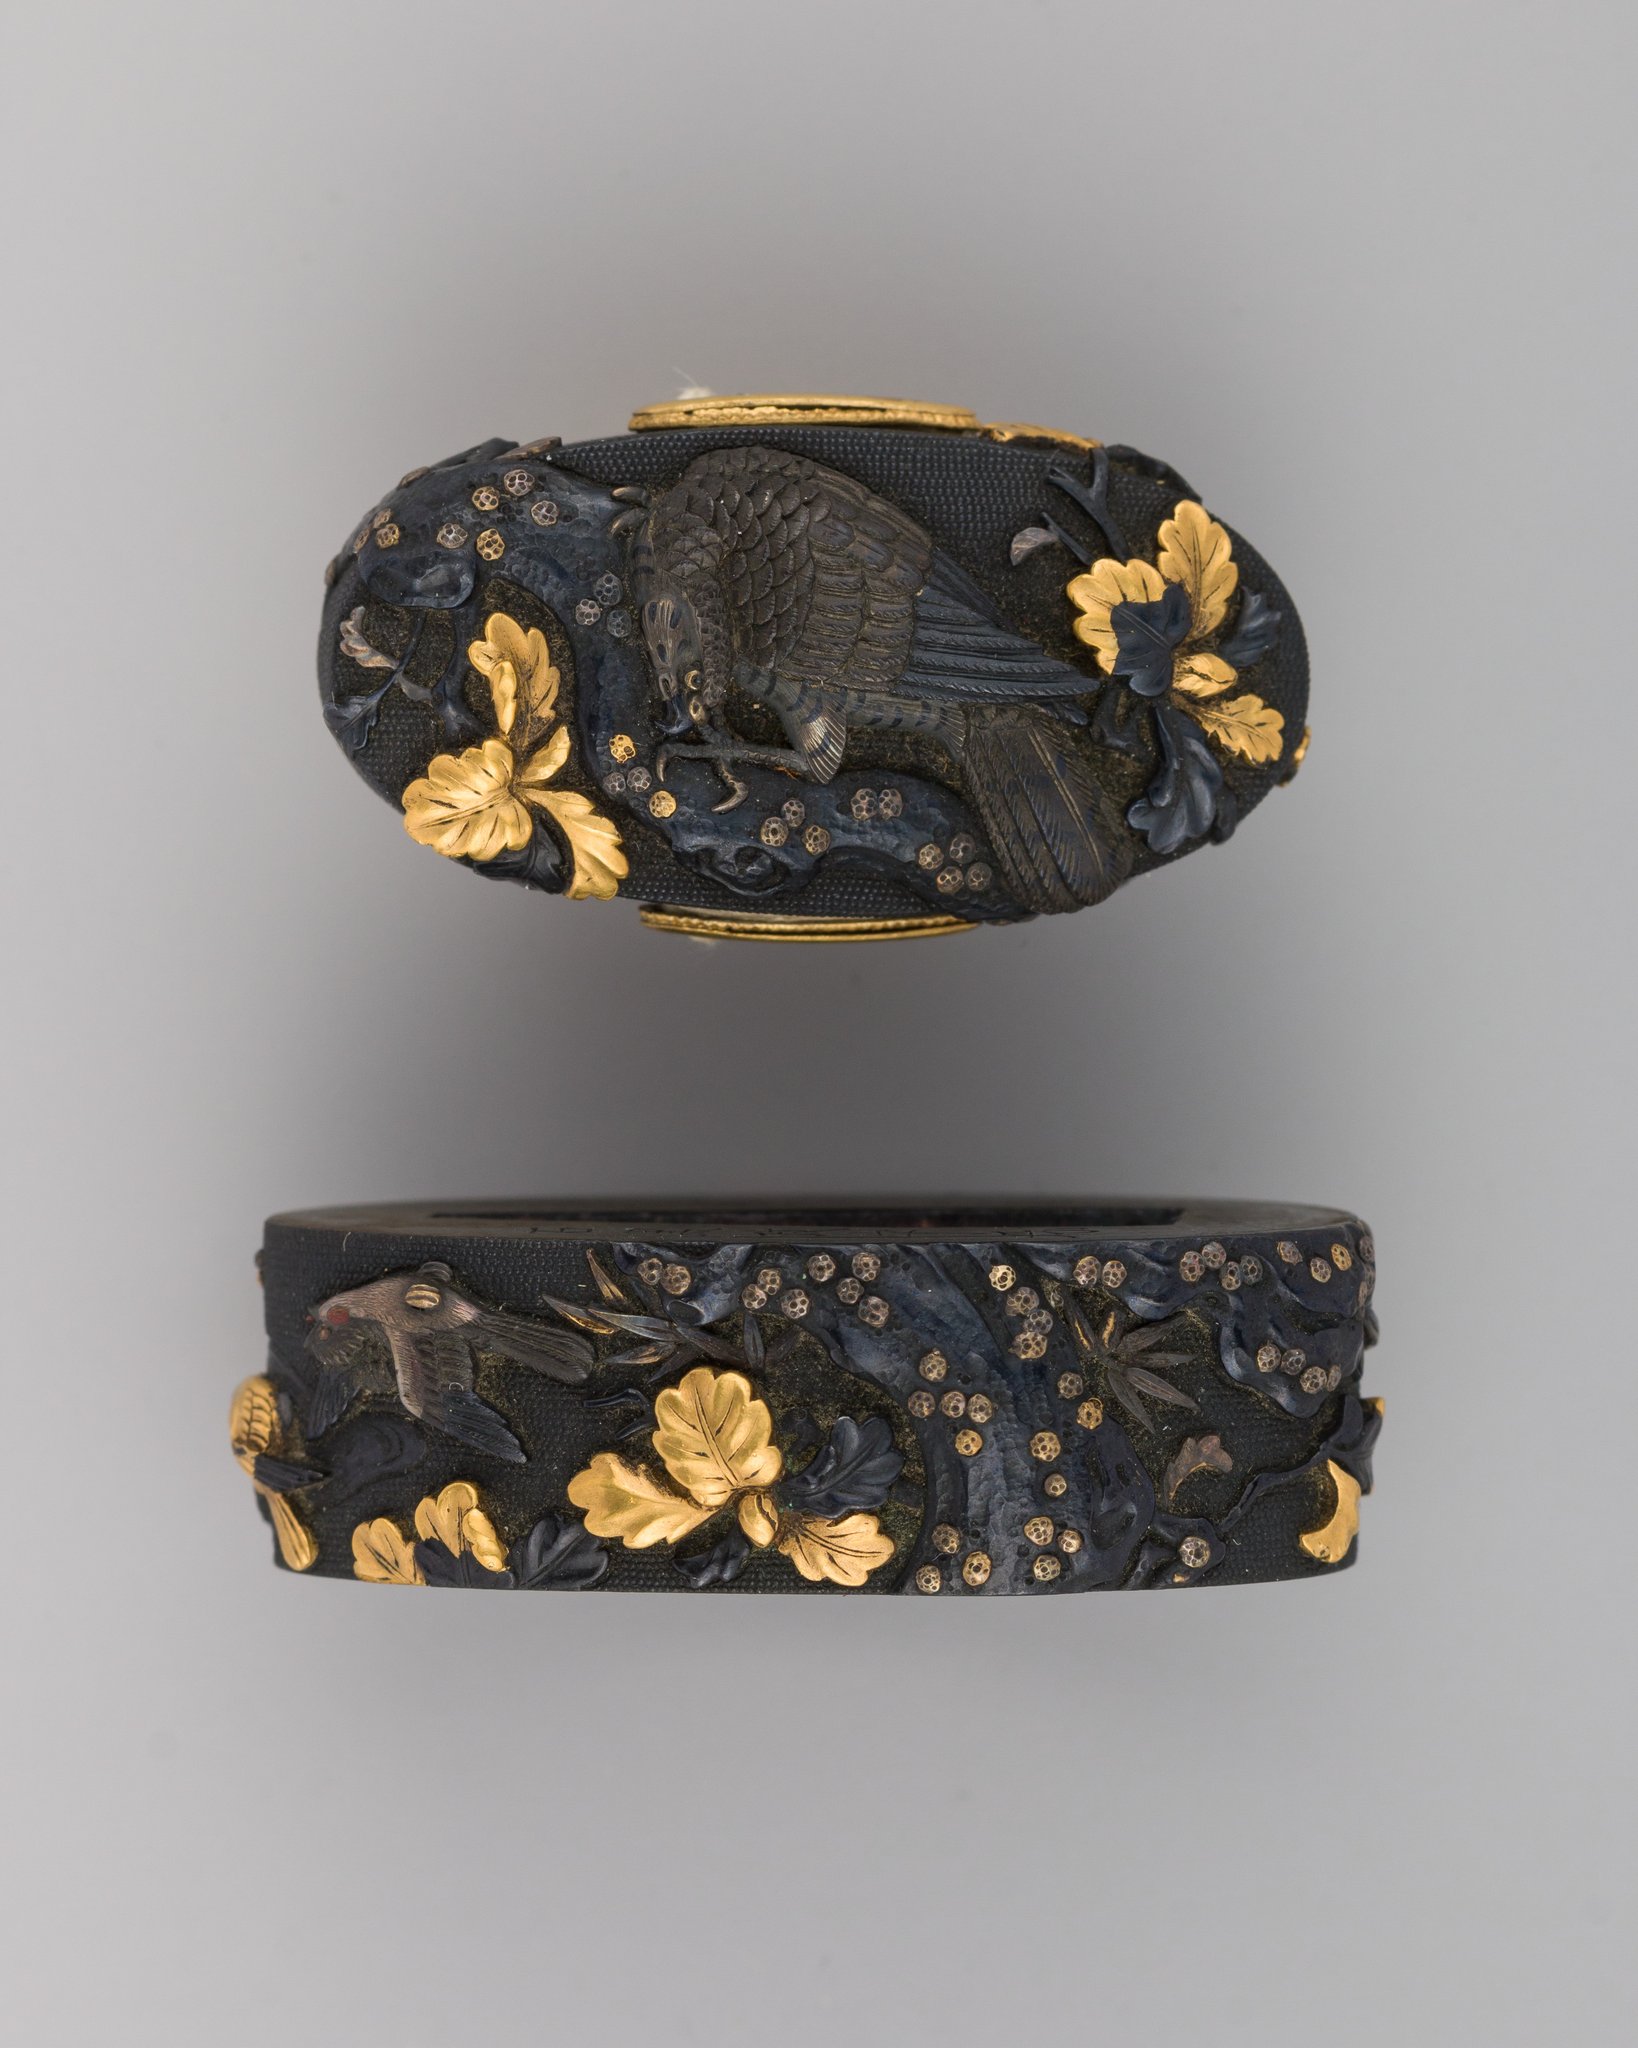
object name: sword hilt collar and pommel fuchigashira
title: Sword-Hilt Collar and Pommel (Fuchigashira)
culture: japanese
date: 1801-1900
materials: gold alloy, gold, silver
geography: japan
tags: birds,flowers